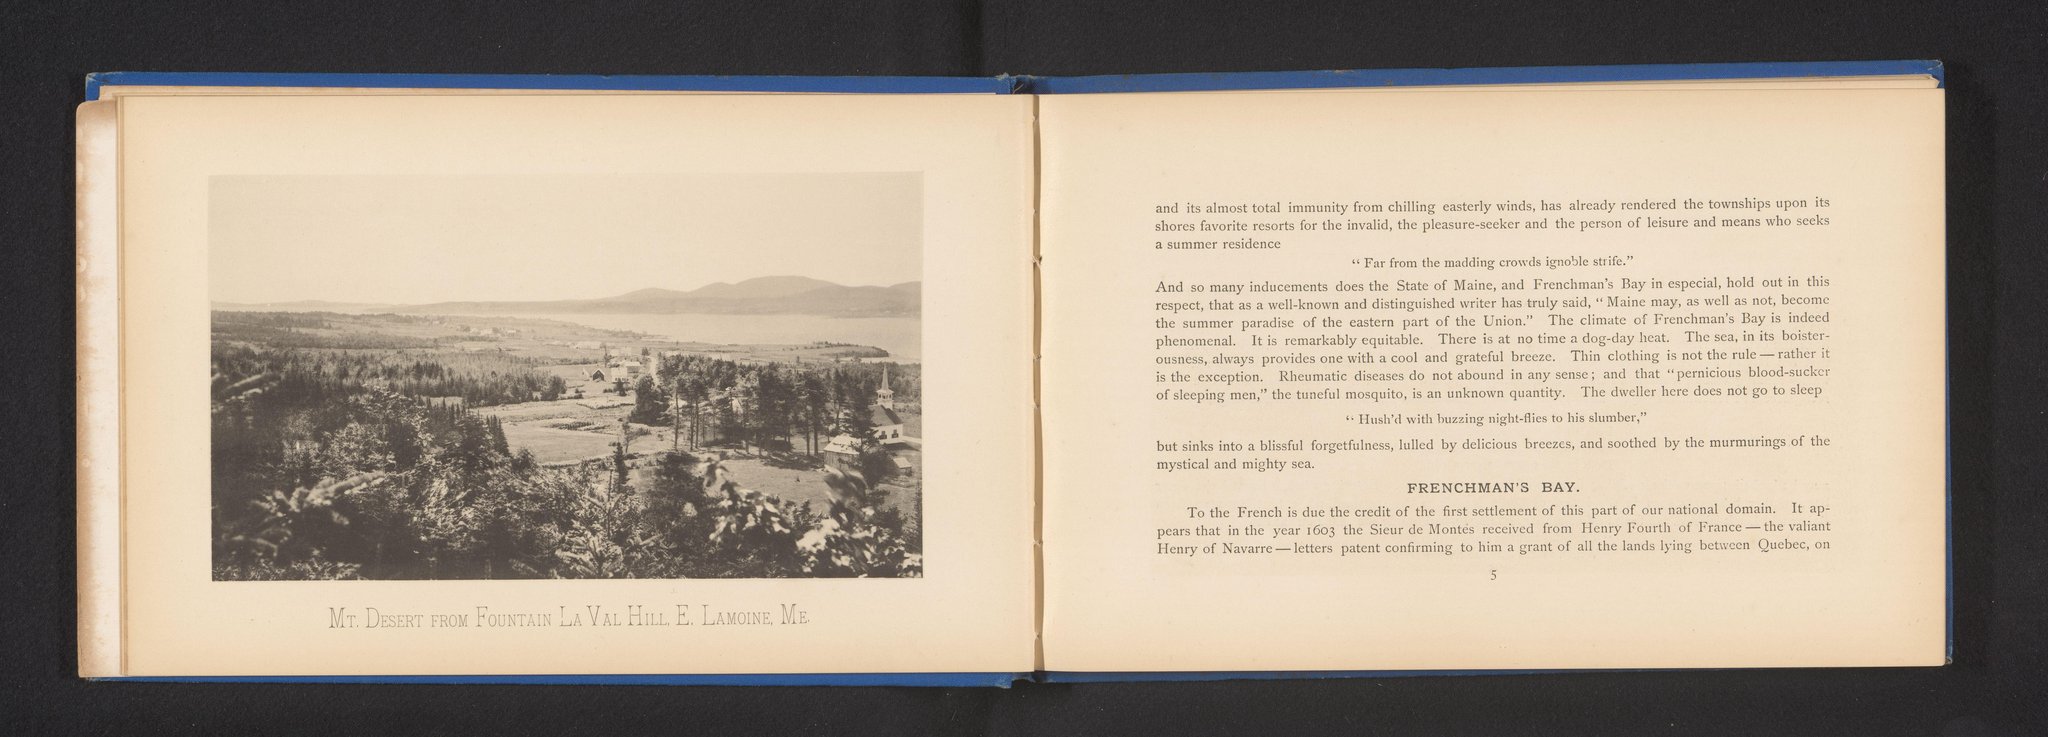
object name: page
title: Gezicht op Mount Desert Island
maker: Anonymous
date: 1882-1887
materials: paper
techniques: photograph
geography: east lamoine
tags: island, landscapes